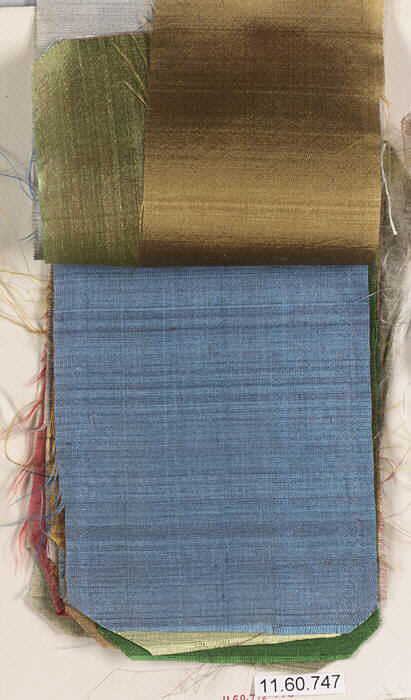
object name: sample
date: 1801-1833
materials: silk